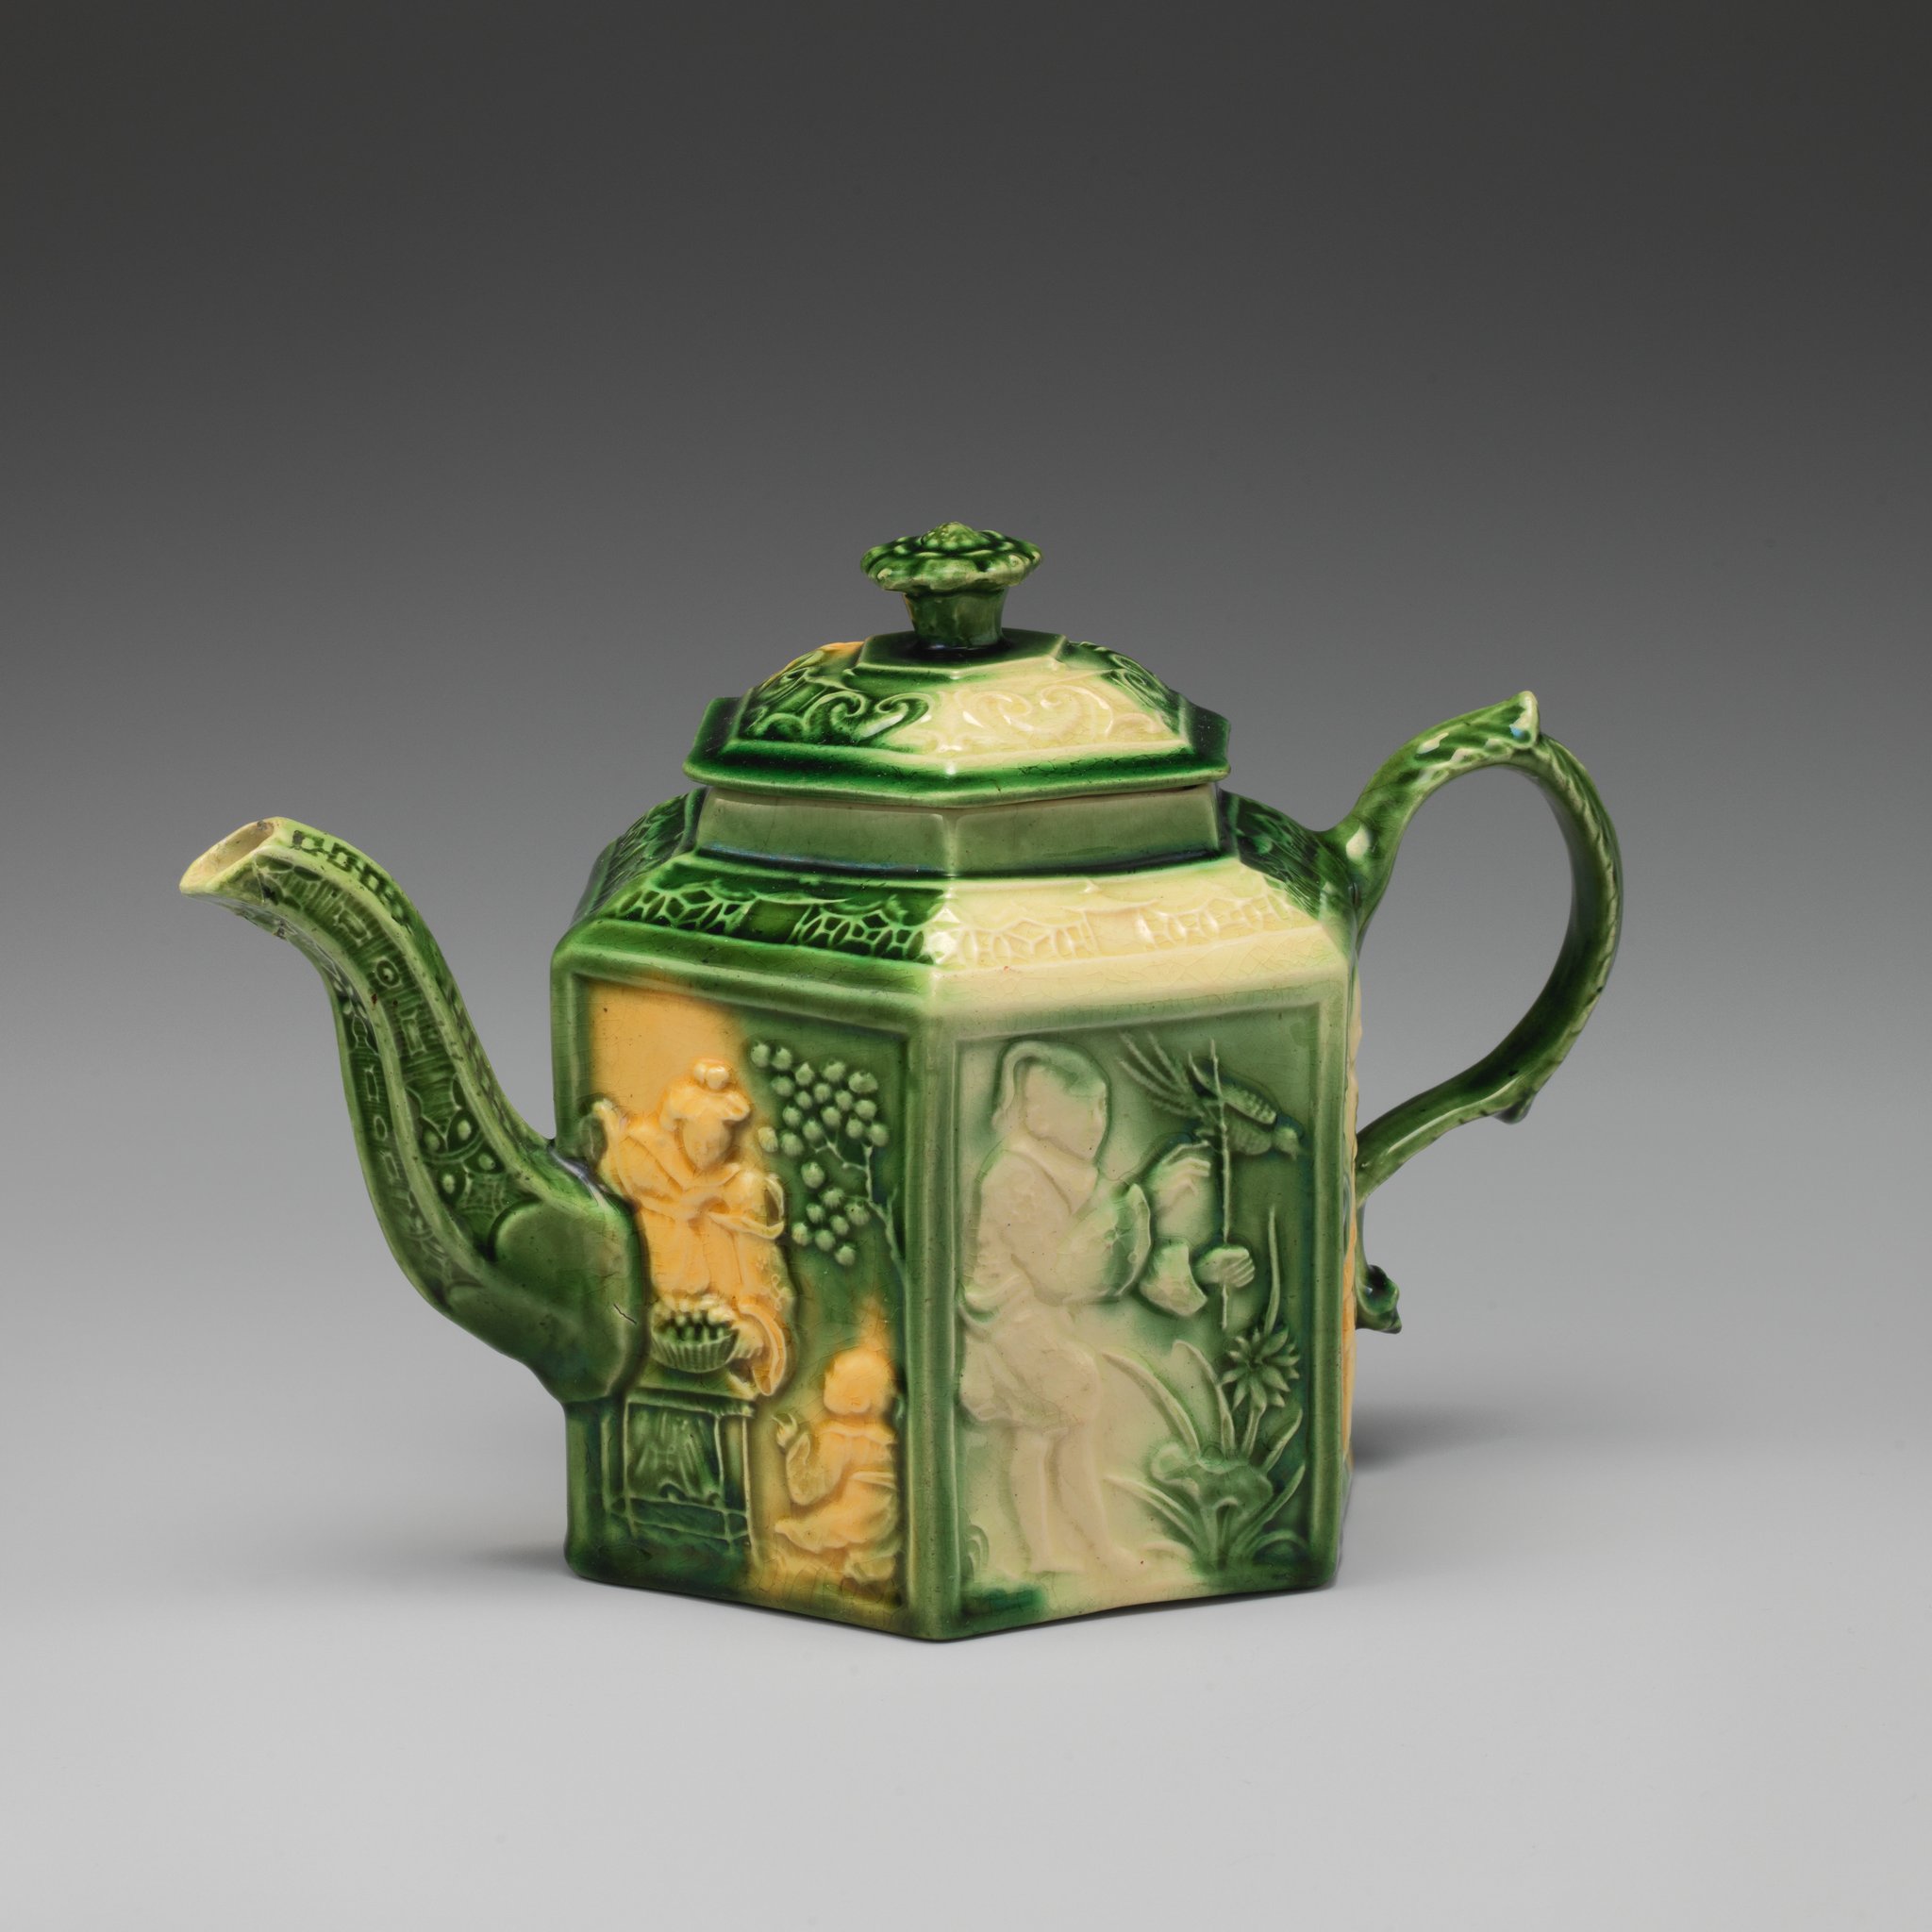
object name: teapot with cover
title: Hexagonal teapot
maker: thomas whieldon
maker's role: maker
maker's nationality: british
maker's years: 1719-1795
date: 1760-1765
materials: earthenware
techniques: glazing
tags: human figures,birds